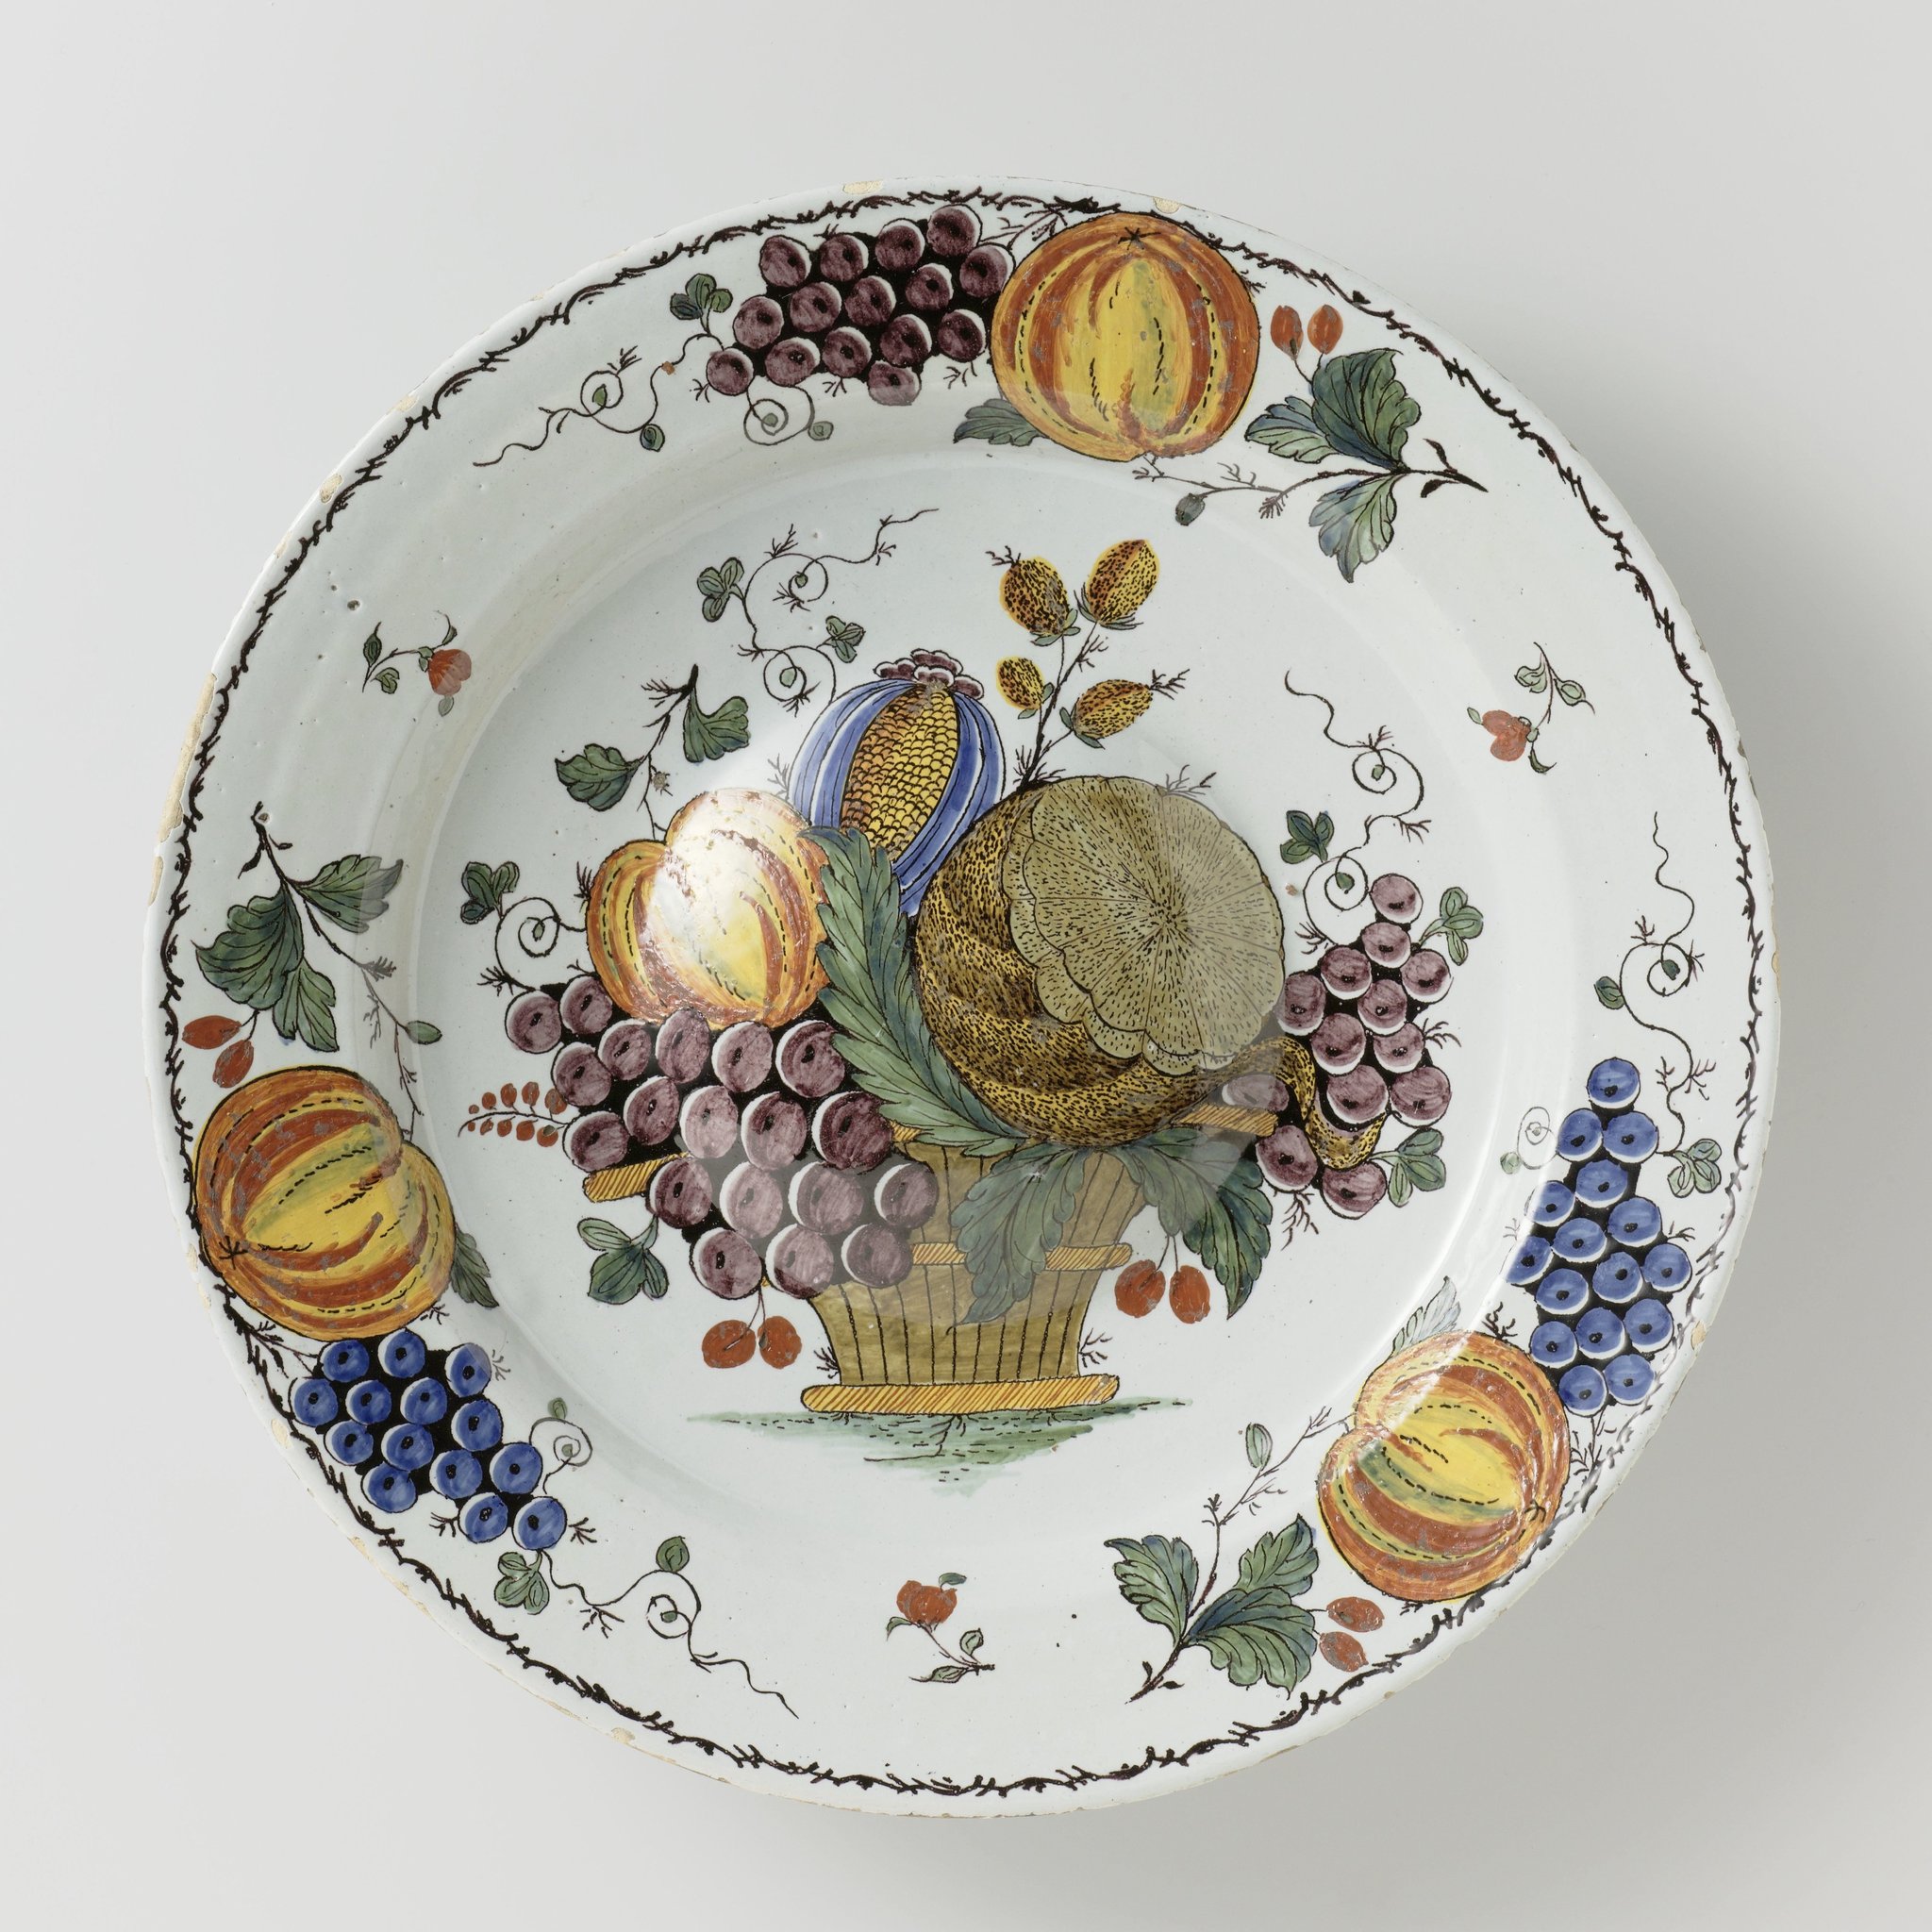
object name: platter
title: Schotel, beschilderd met een fruitmand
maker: Anonymous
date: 1776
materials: earthenware, glaze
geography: delft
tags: fruits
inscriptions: date: ‘1776’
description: Schotel van faïence, veelkleurig beschilderd met een fruitmand.